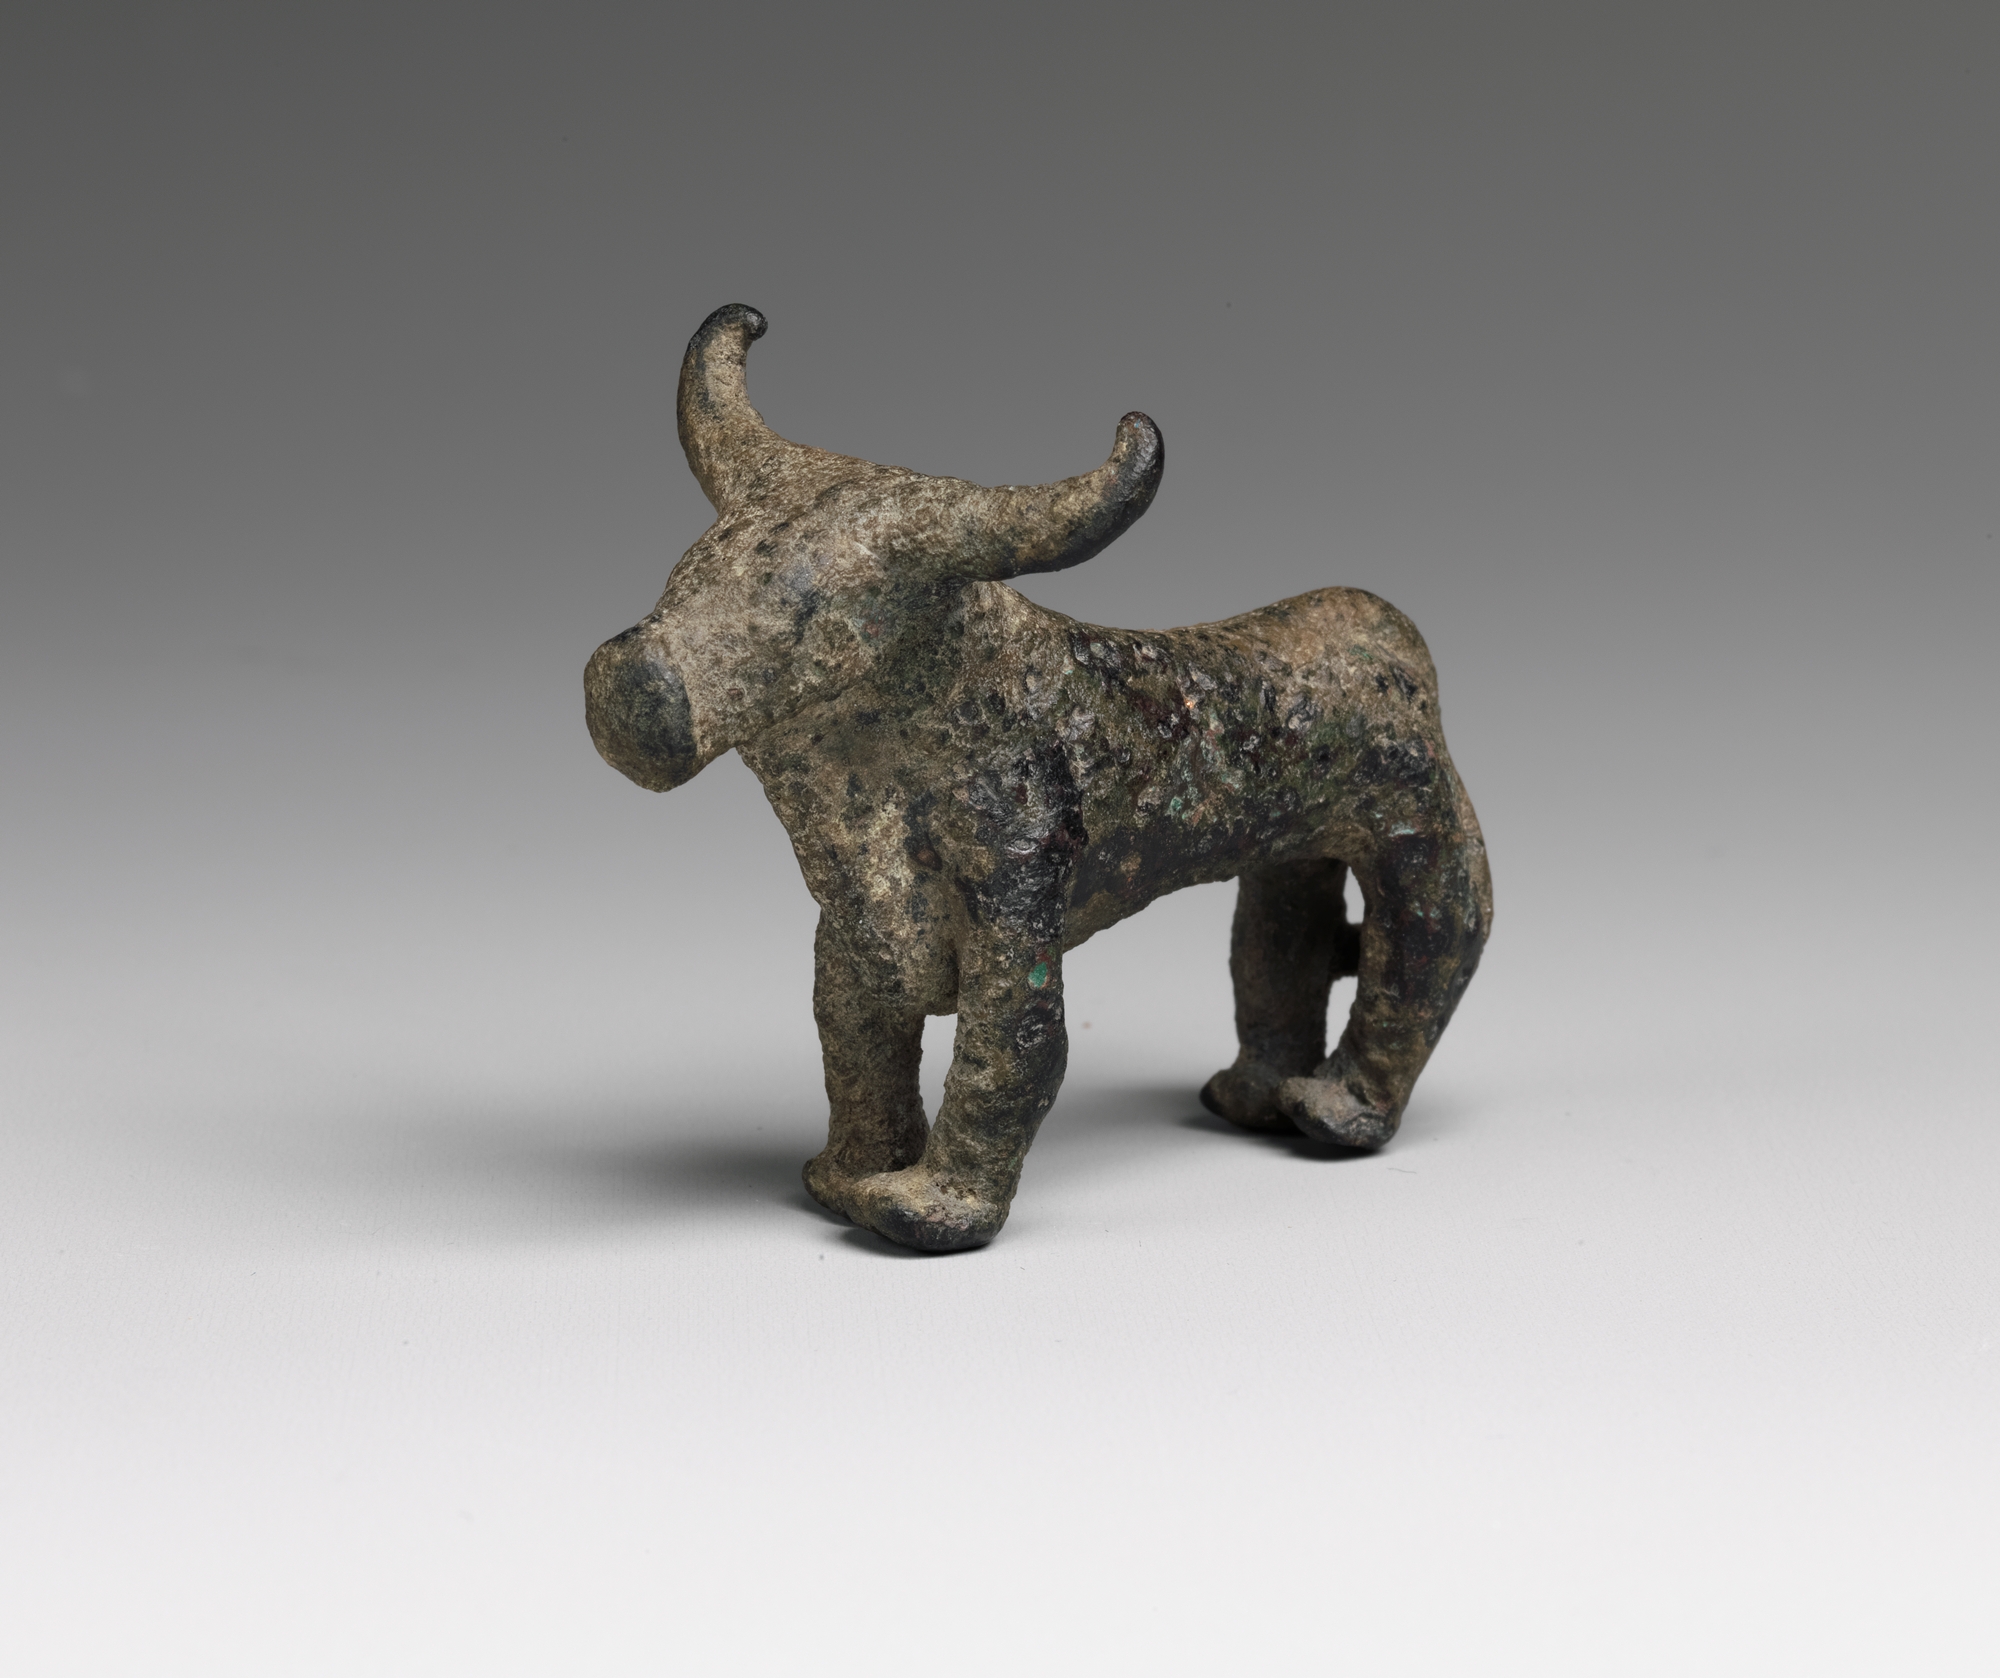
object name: statuette of a bull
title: Bronze bull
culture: minoan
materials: bronze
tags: bulls